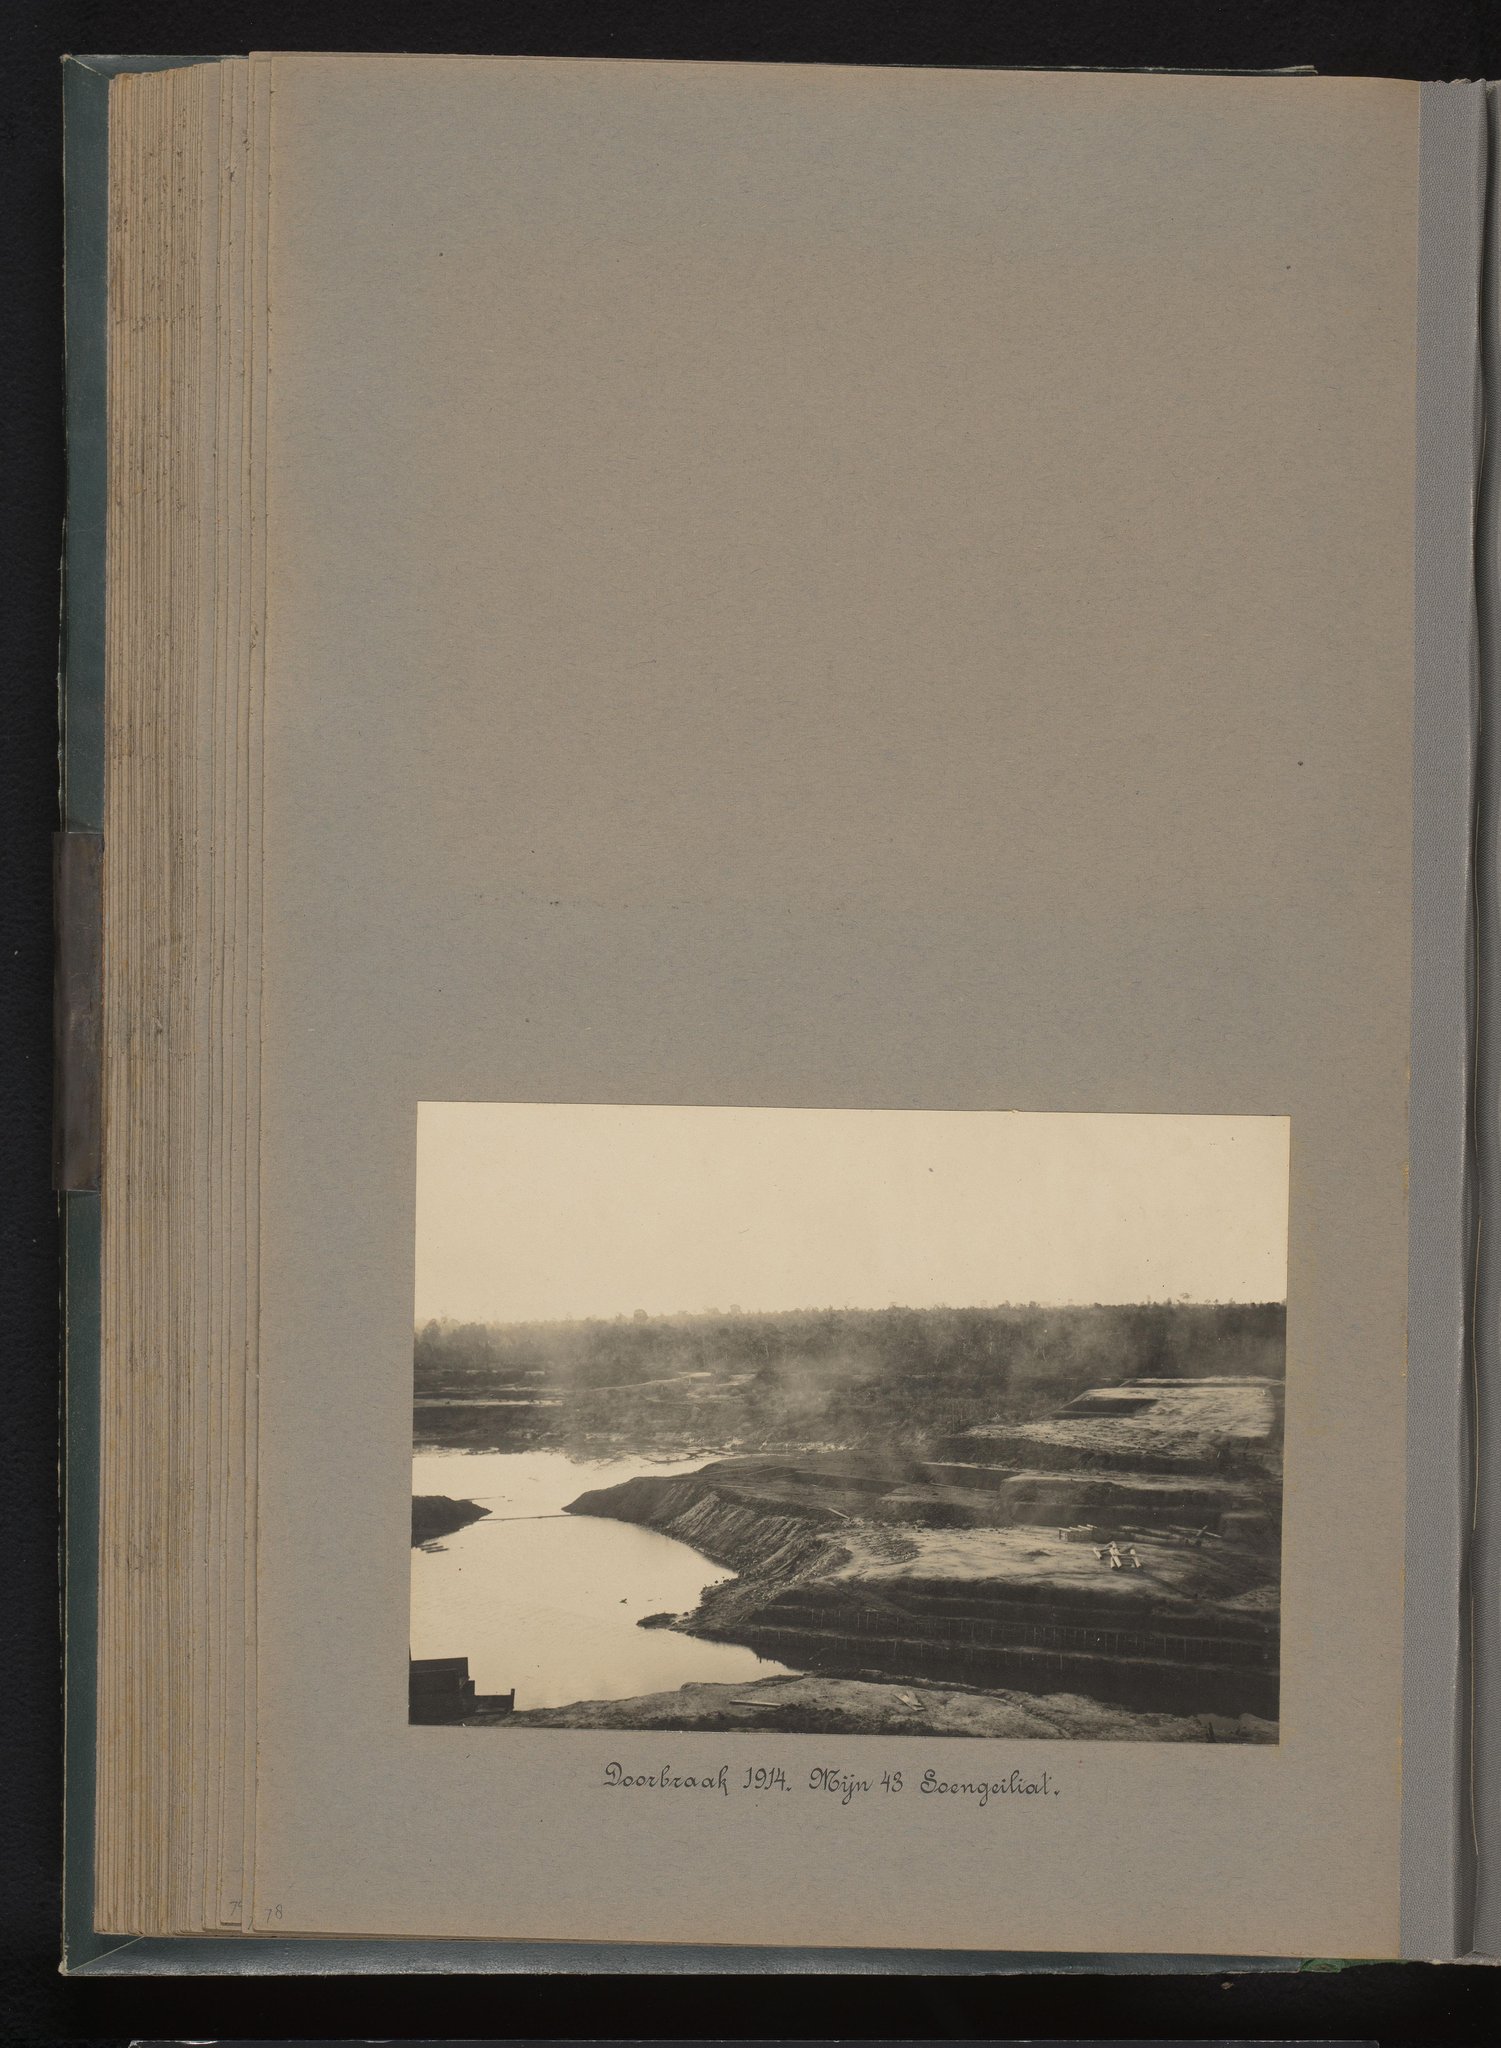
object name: album leaf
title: Doorbraak bij een mijn te Soengeiliat in 1914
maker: Anonymous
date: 1914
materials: cardboard, photographic support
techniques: gelatin silver print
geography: bangka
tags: robert julius boers, colonial system, dike-break, mining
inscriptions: inscription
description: Albumblad met 1 foto van een doorbraak en overstroming in 1914 van een mijn van de Banka-tinwinning te Soengeiliat. Onderdeel van het fotoalbum aangeboden aan Robert Julius Boers bij zijn vertrek naar Nederland in 1919 door het personeel van de Banka-tinwinning.